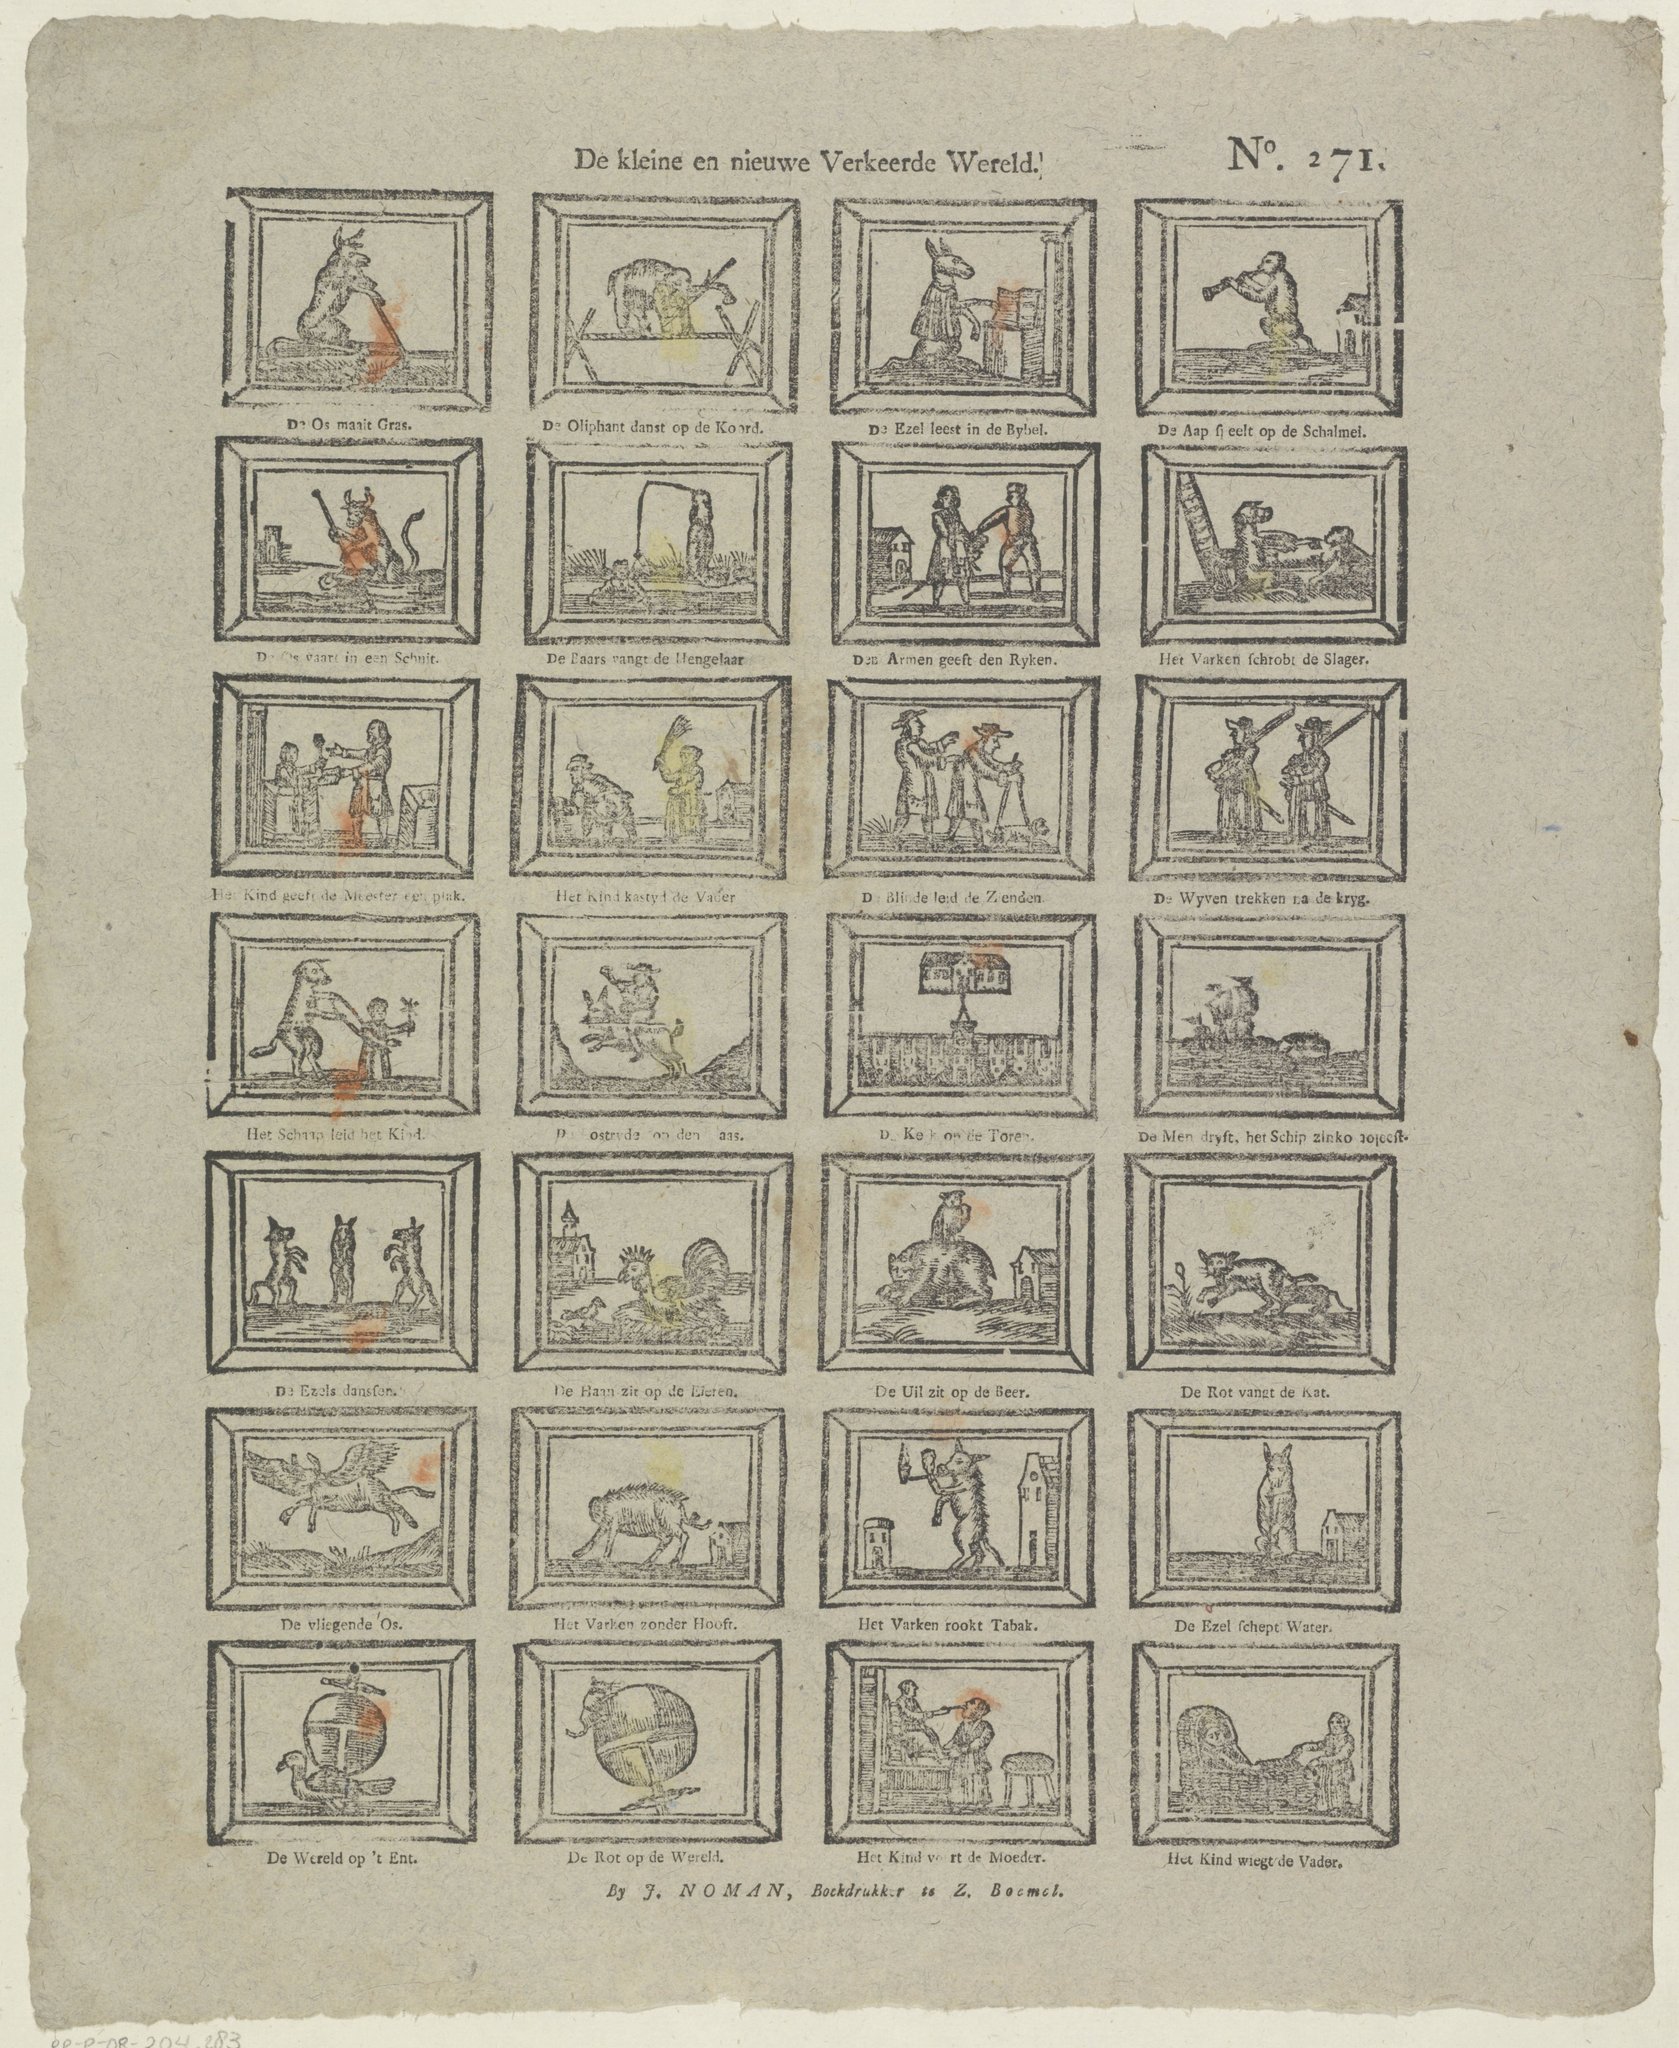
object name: popular print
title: De kleine en nieuwe Verkeerde Wereld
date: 1806-1830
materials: paper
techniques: colour, letterpress printing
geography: zaltbommel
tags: 'mundus inversus', the reversed world, the topsy-turvy world, 'le monde bestourné', animals acting as human beings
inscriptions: collector's mark: Lugt 2760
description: Blad met 28 voorstellingen over de verkeerde wereld, waar onder andere dieren zich als mensen gedragen. Onder elke afbeelding een onderschrift. Genummerd rechtsboven: No. 271.